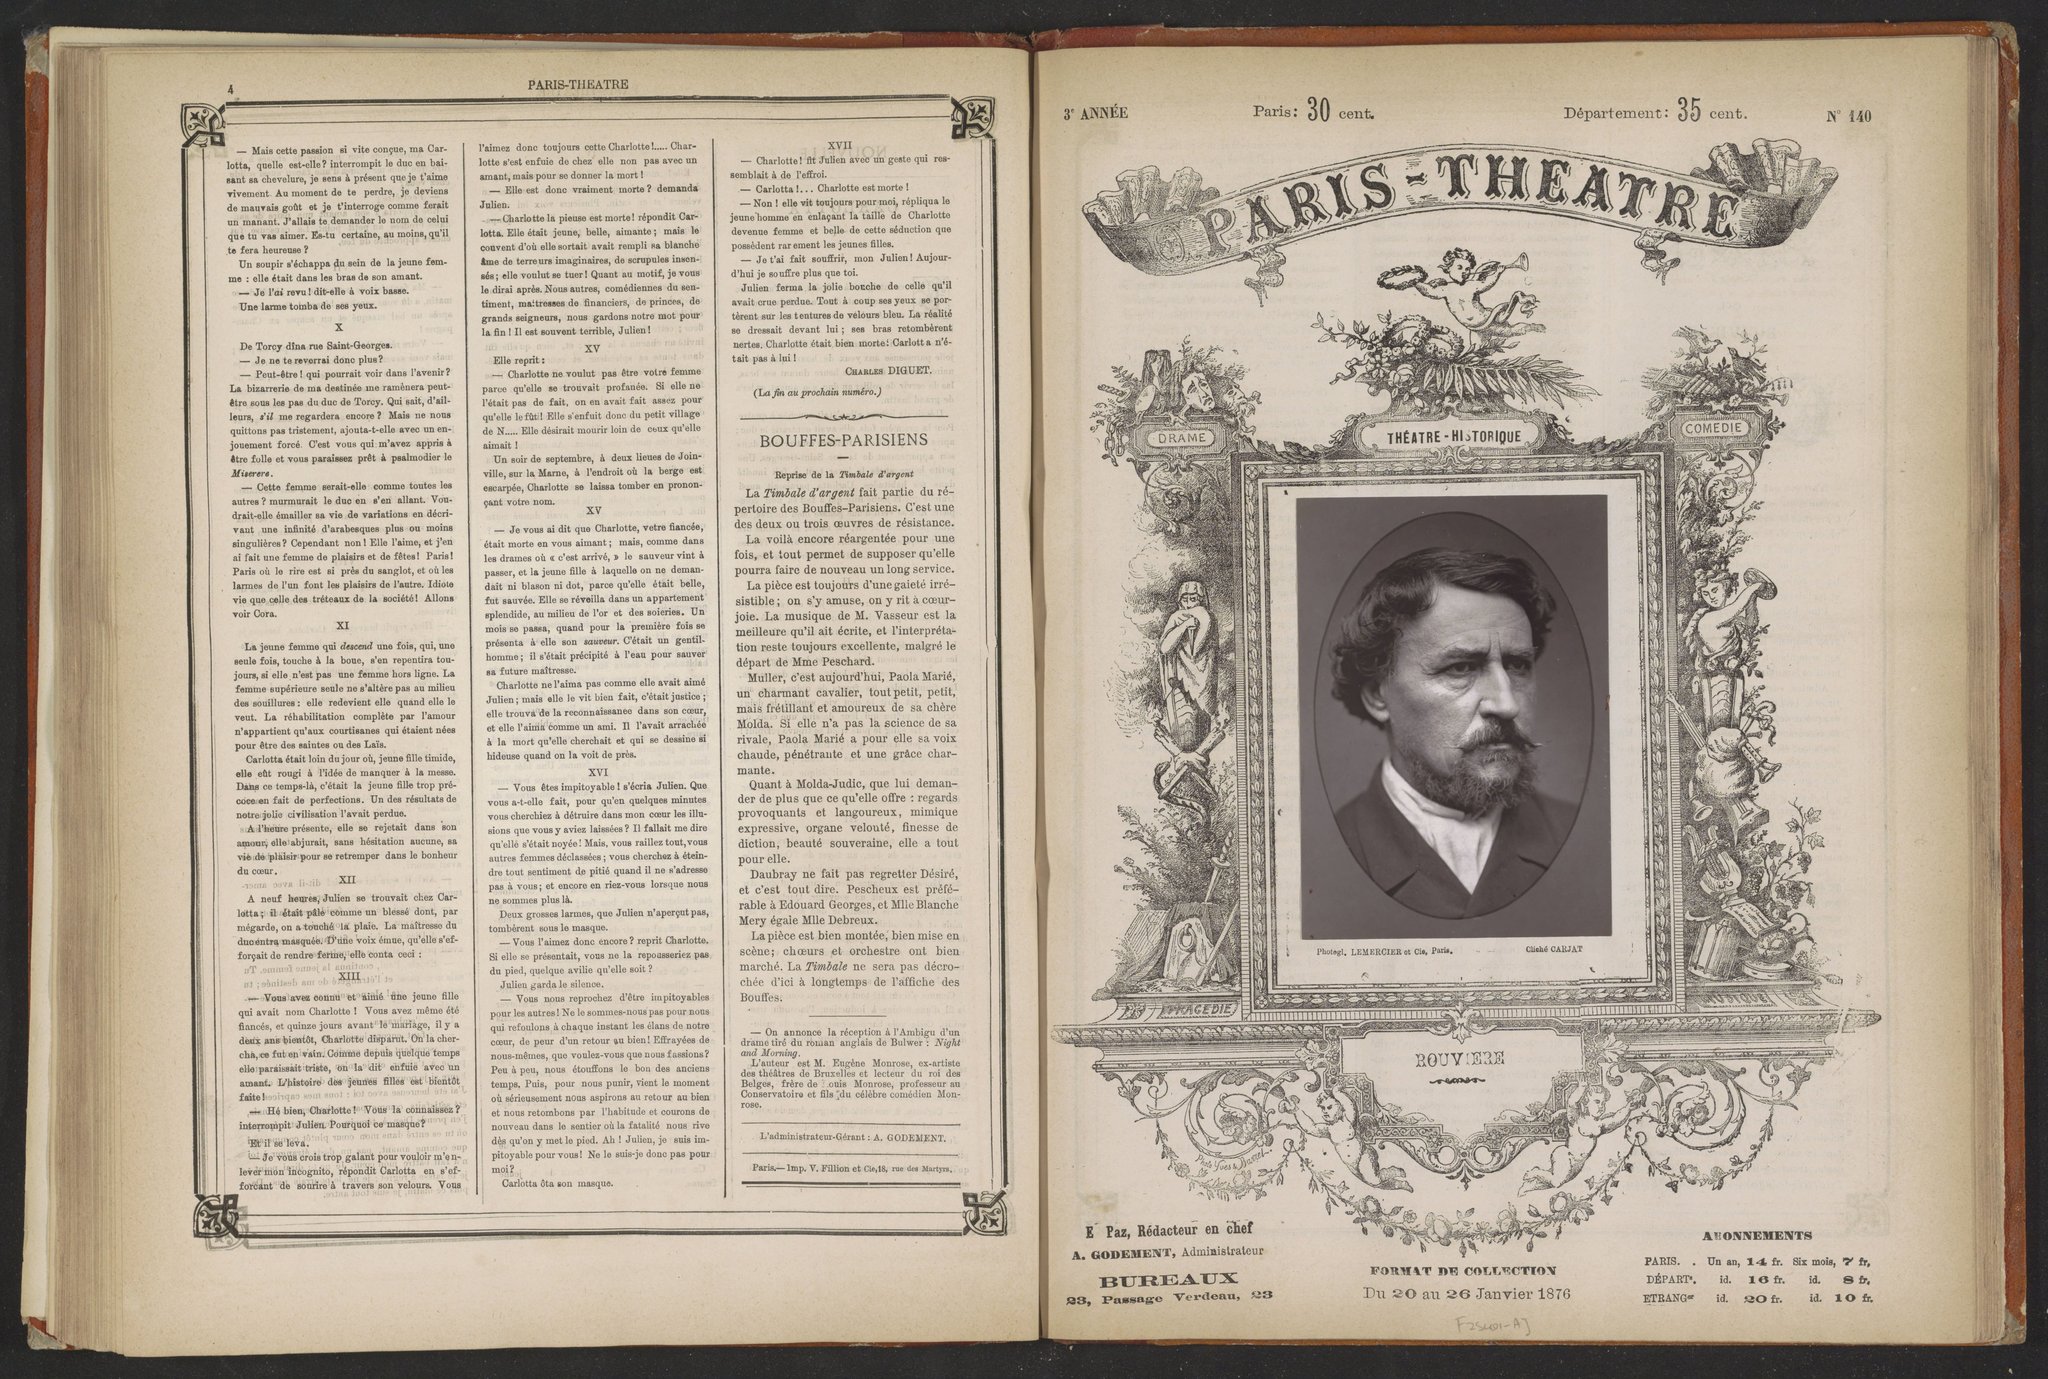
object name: page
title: Portret van Philibert Rouvière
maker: étienne carjat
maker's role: draughtsman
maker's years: 1828-1906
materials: paper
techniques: woodburytype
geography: paris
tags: portrait of actor, actress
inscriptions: inscription: ‘Du 20 au 26 Janvier 1876’, number: ‘No 140’